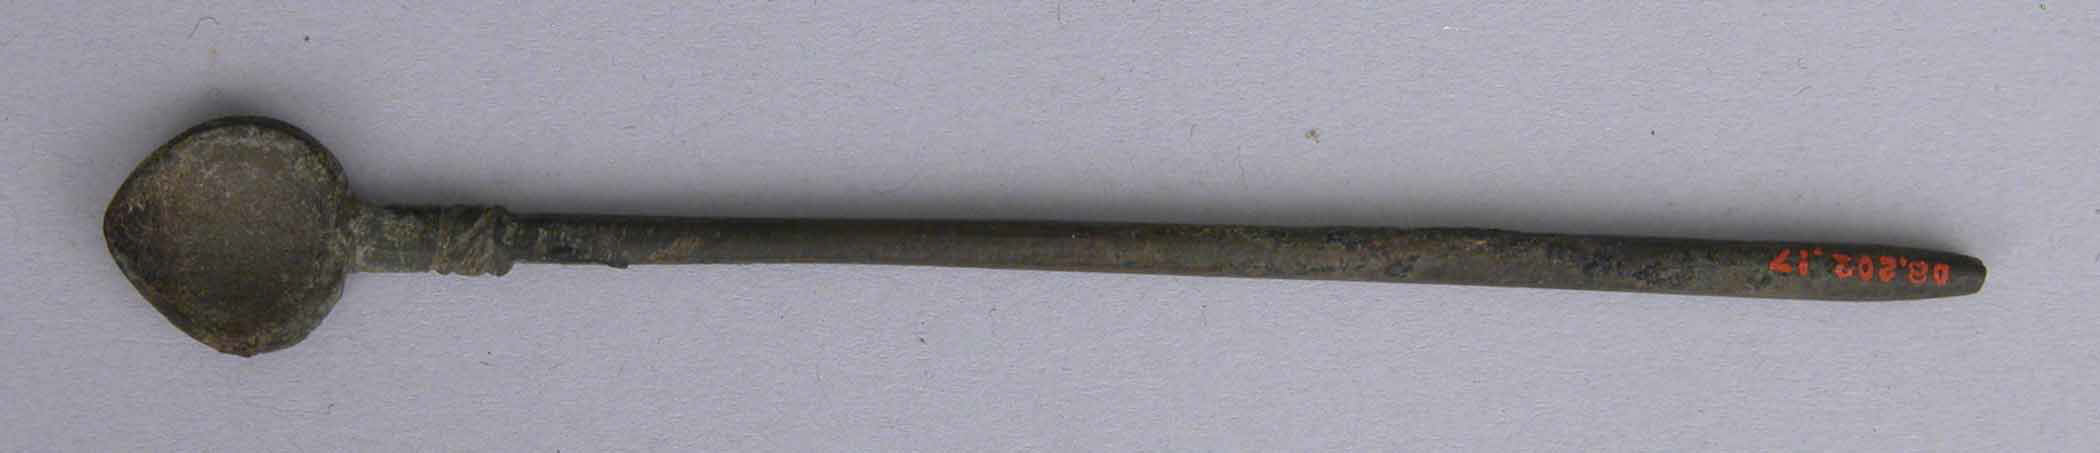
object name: spoon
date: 201-700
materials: metal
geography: egypt